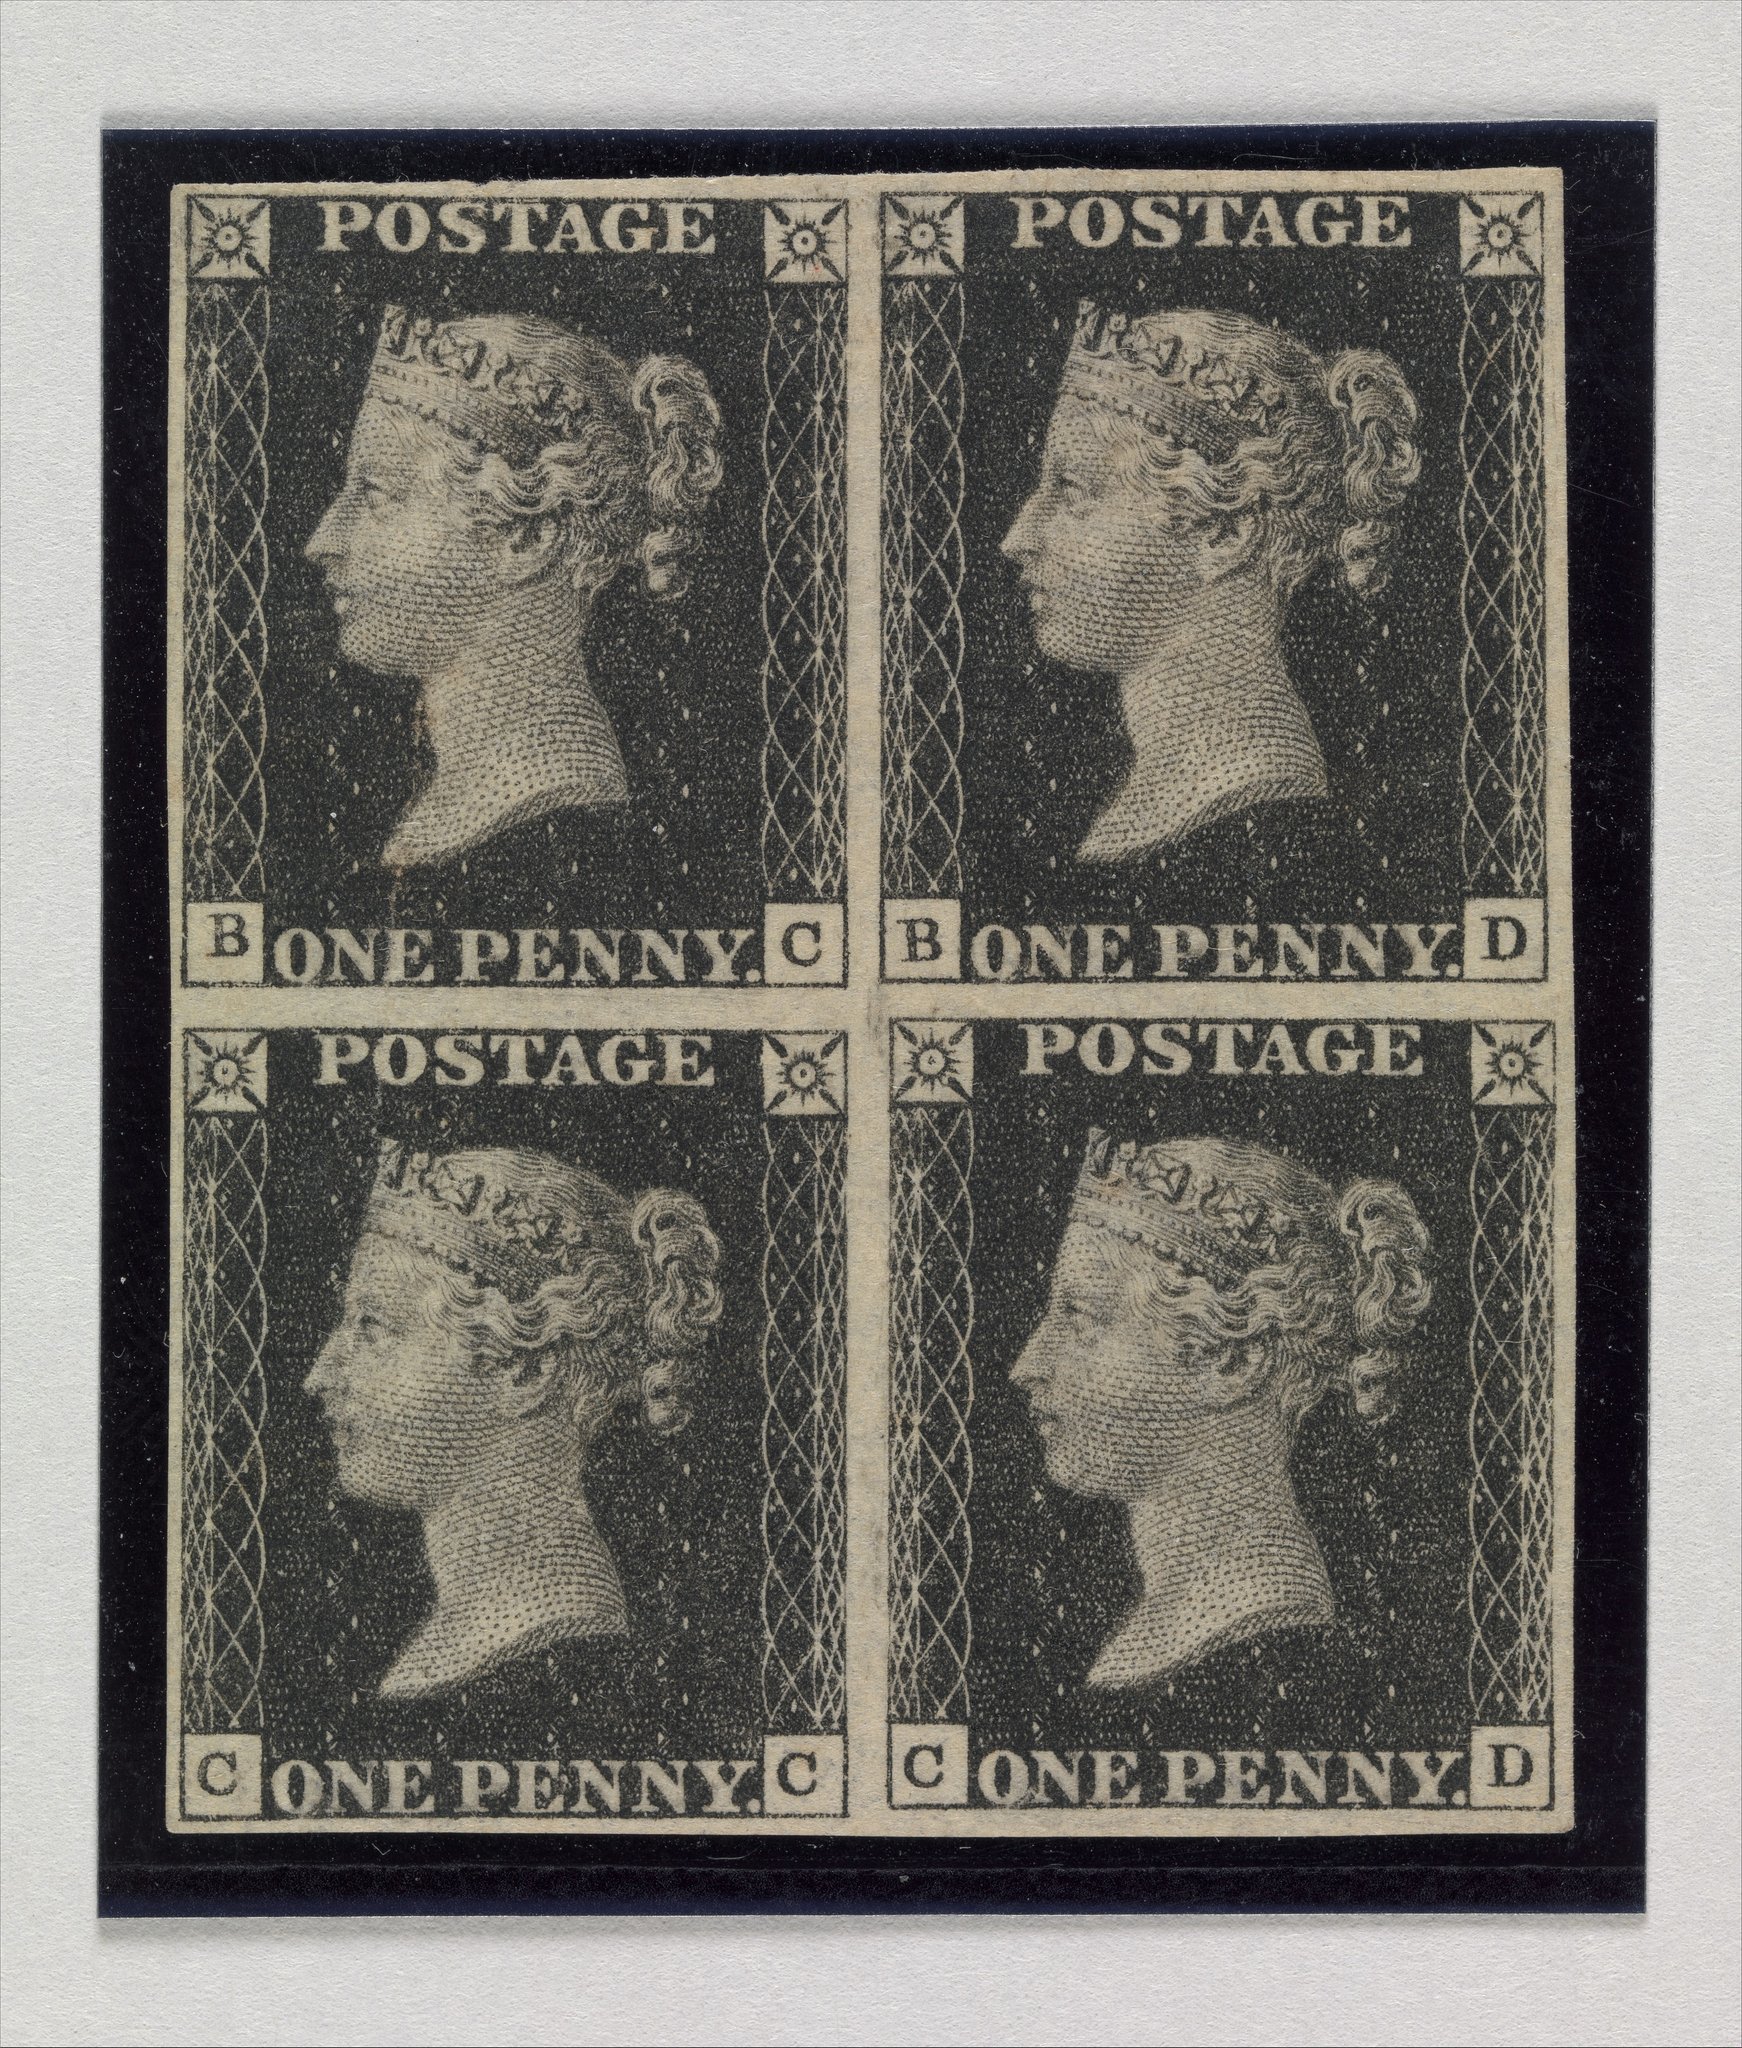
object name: postage stamp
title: Unused block of four "Penny Black" postage stamps of Queen Victoria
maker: william wyon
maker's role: artist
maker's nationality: british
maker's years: 1795-1851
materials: ink, paper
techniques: engraving, printing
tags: women,queen victoria